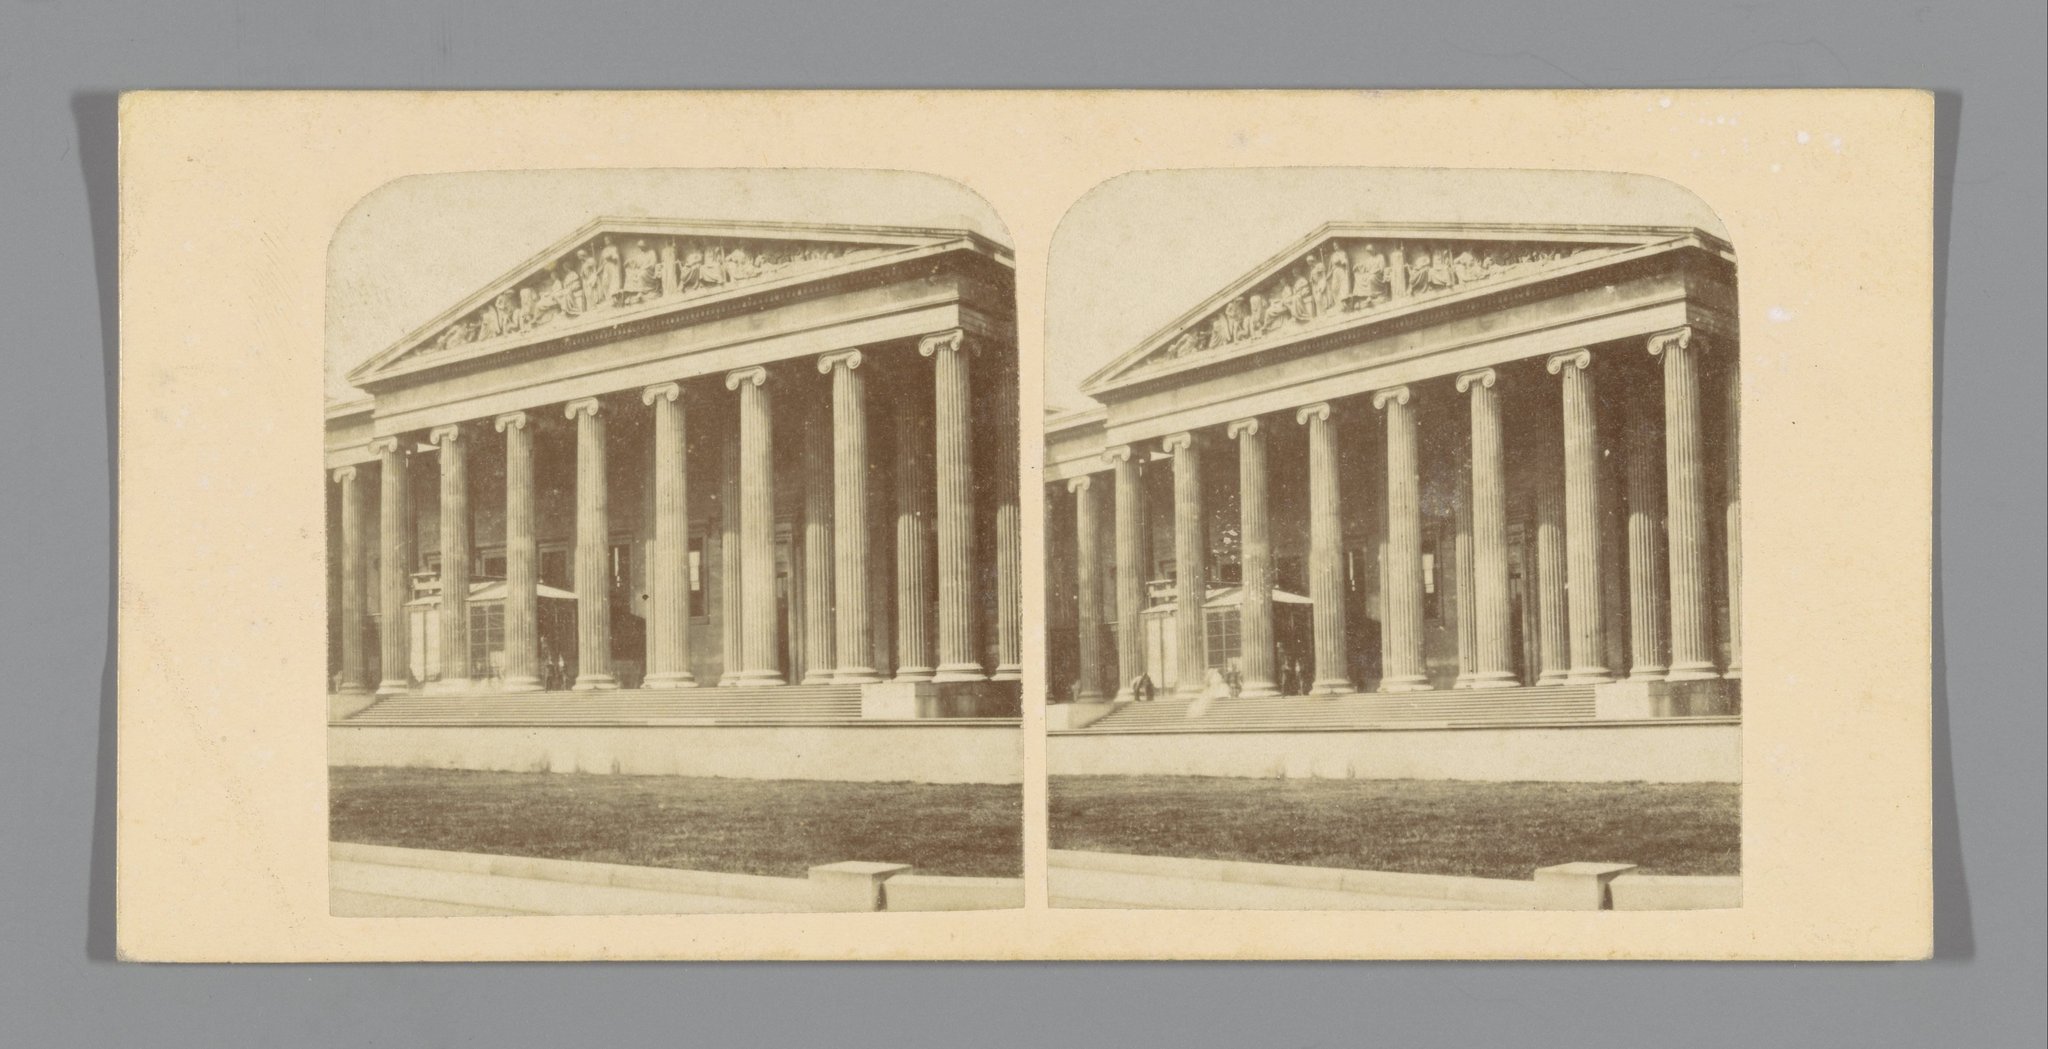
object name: stereograph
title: British Museum in Londen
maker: Anonymous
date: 1850-1880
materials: cardboard, photographic support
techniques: albumen print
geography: london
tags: permanent exhibition, museum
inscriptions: number: ‘62.’